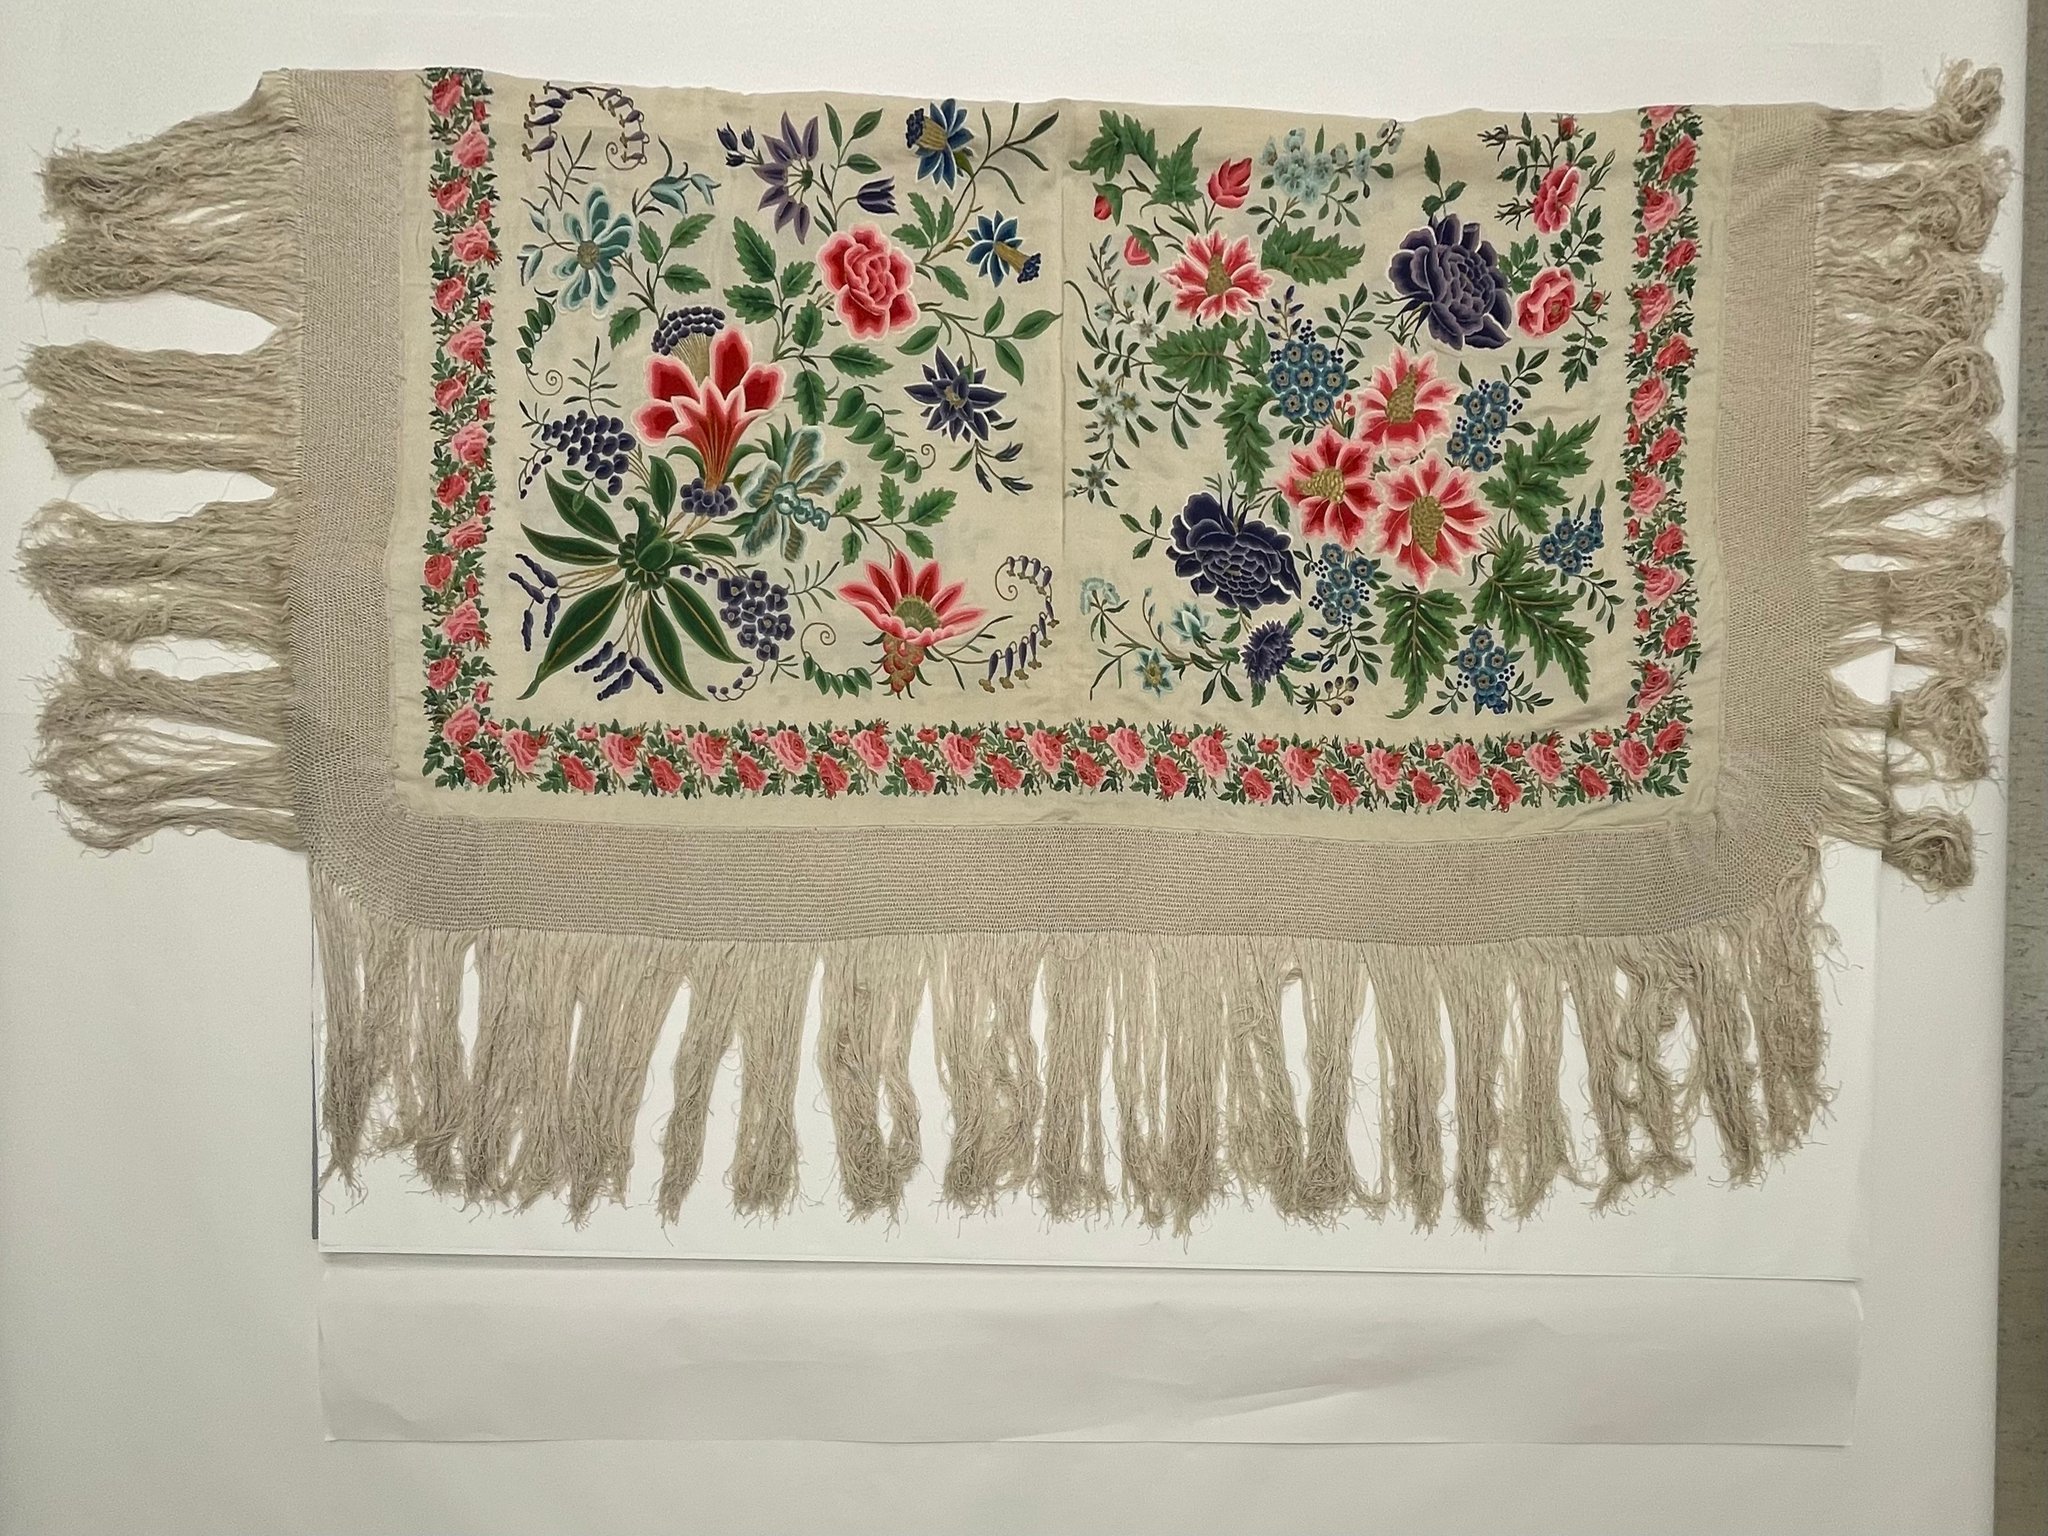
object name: shawl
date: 1801-1900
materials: metal thread, silk